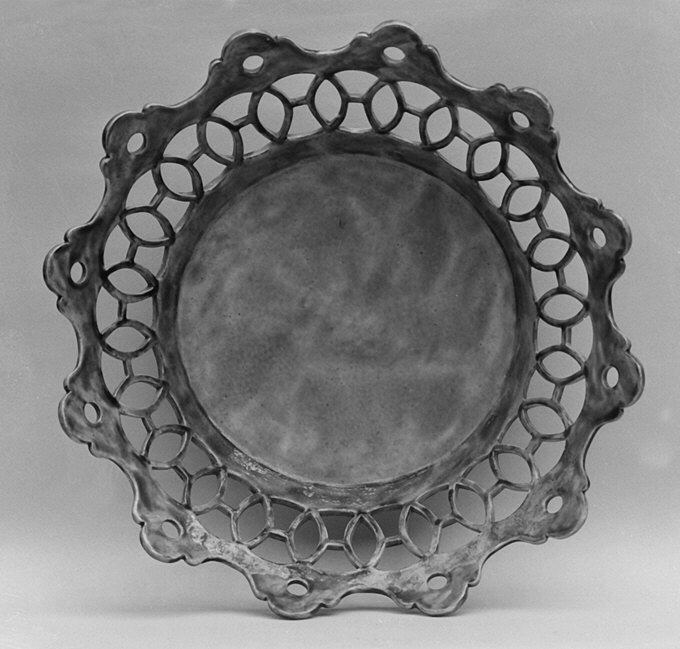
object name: basket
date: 1760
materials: stoneware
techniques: salt glaze